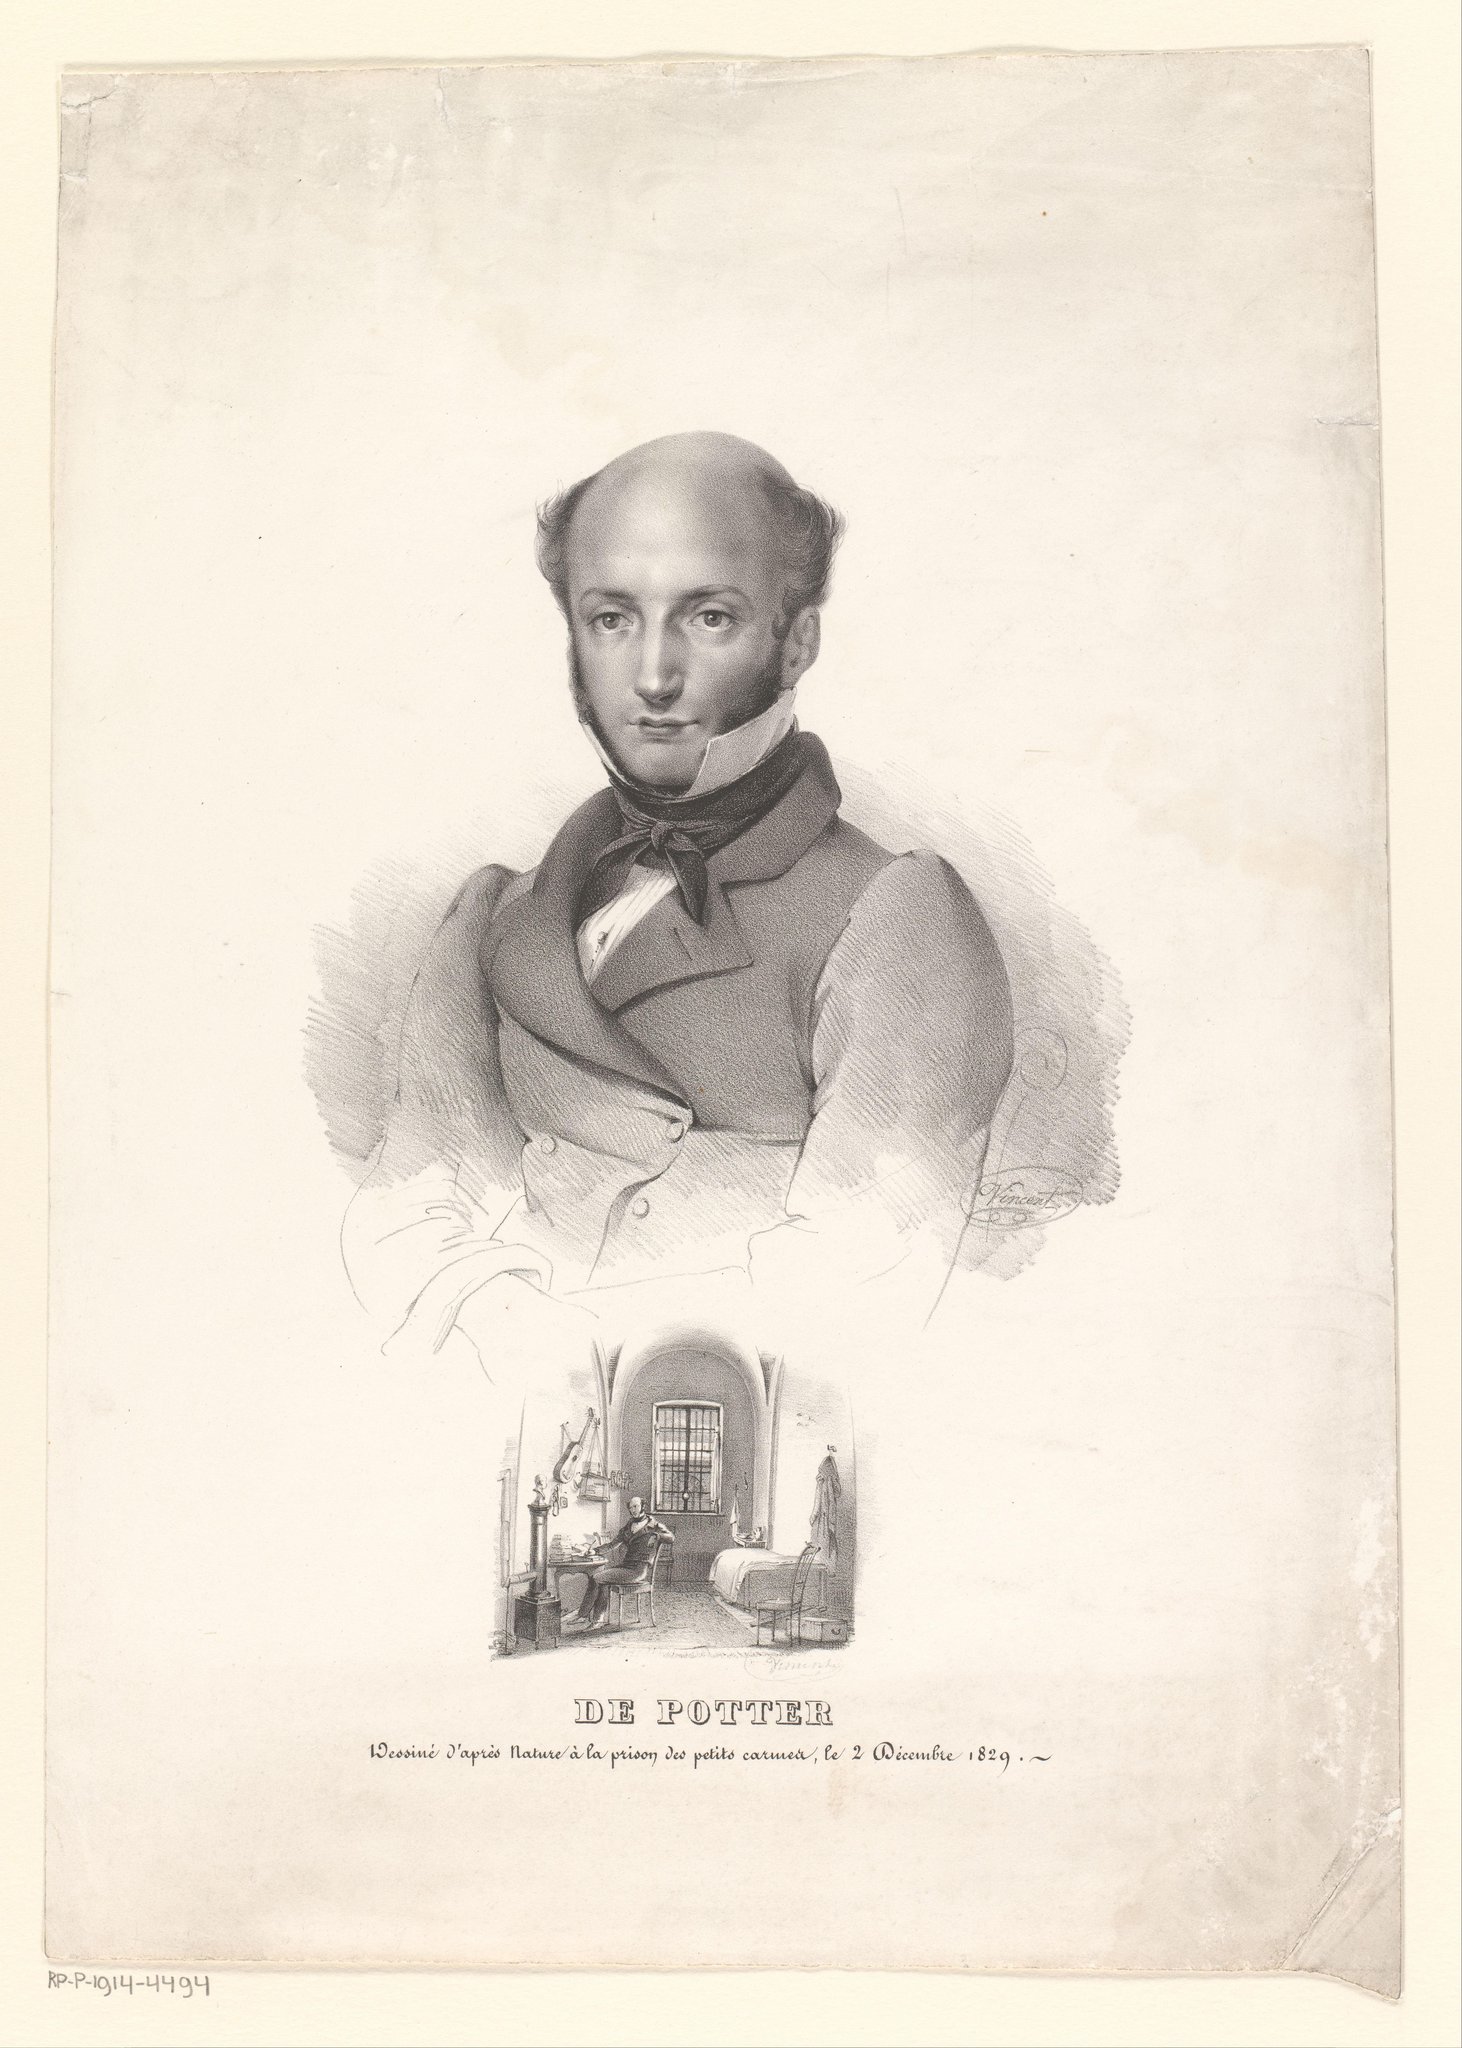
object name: print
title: De Potter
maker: d. vincent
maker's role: print maker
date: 1829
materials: paper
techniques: lithograph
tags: bruges, politician, prison, jail, journalist, reporter, historical persons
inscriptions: collector's mark: Lugt 2228